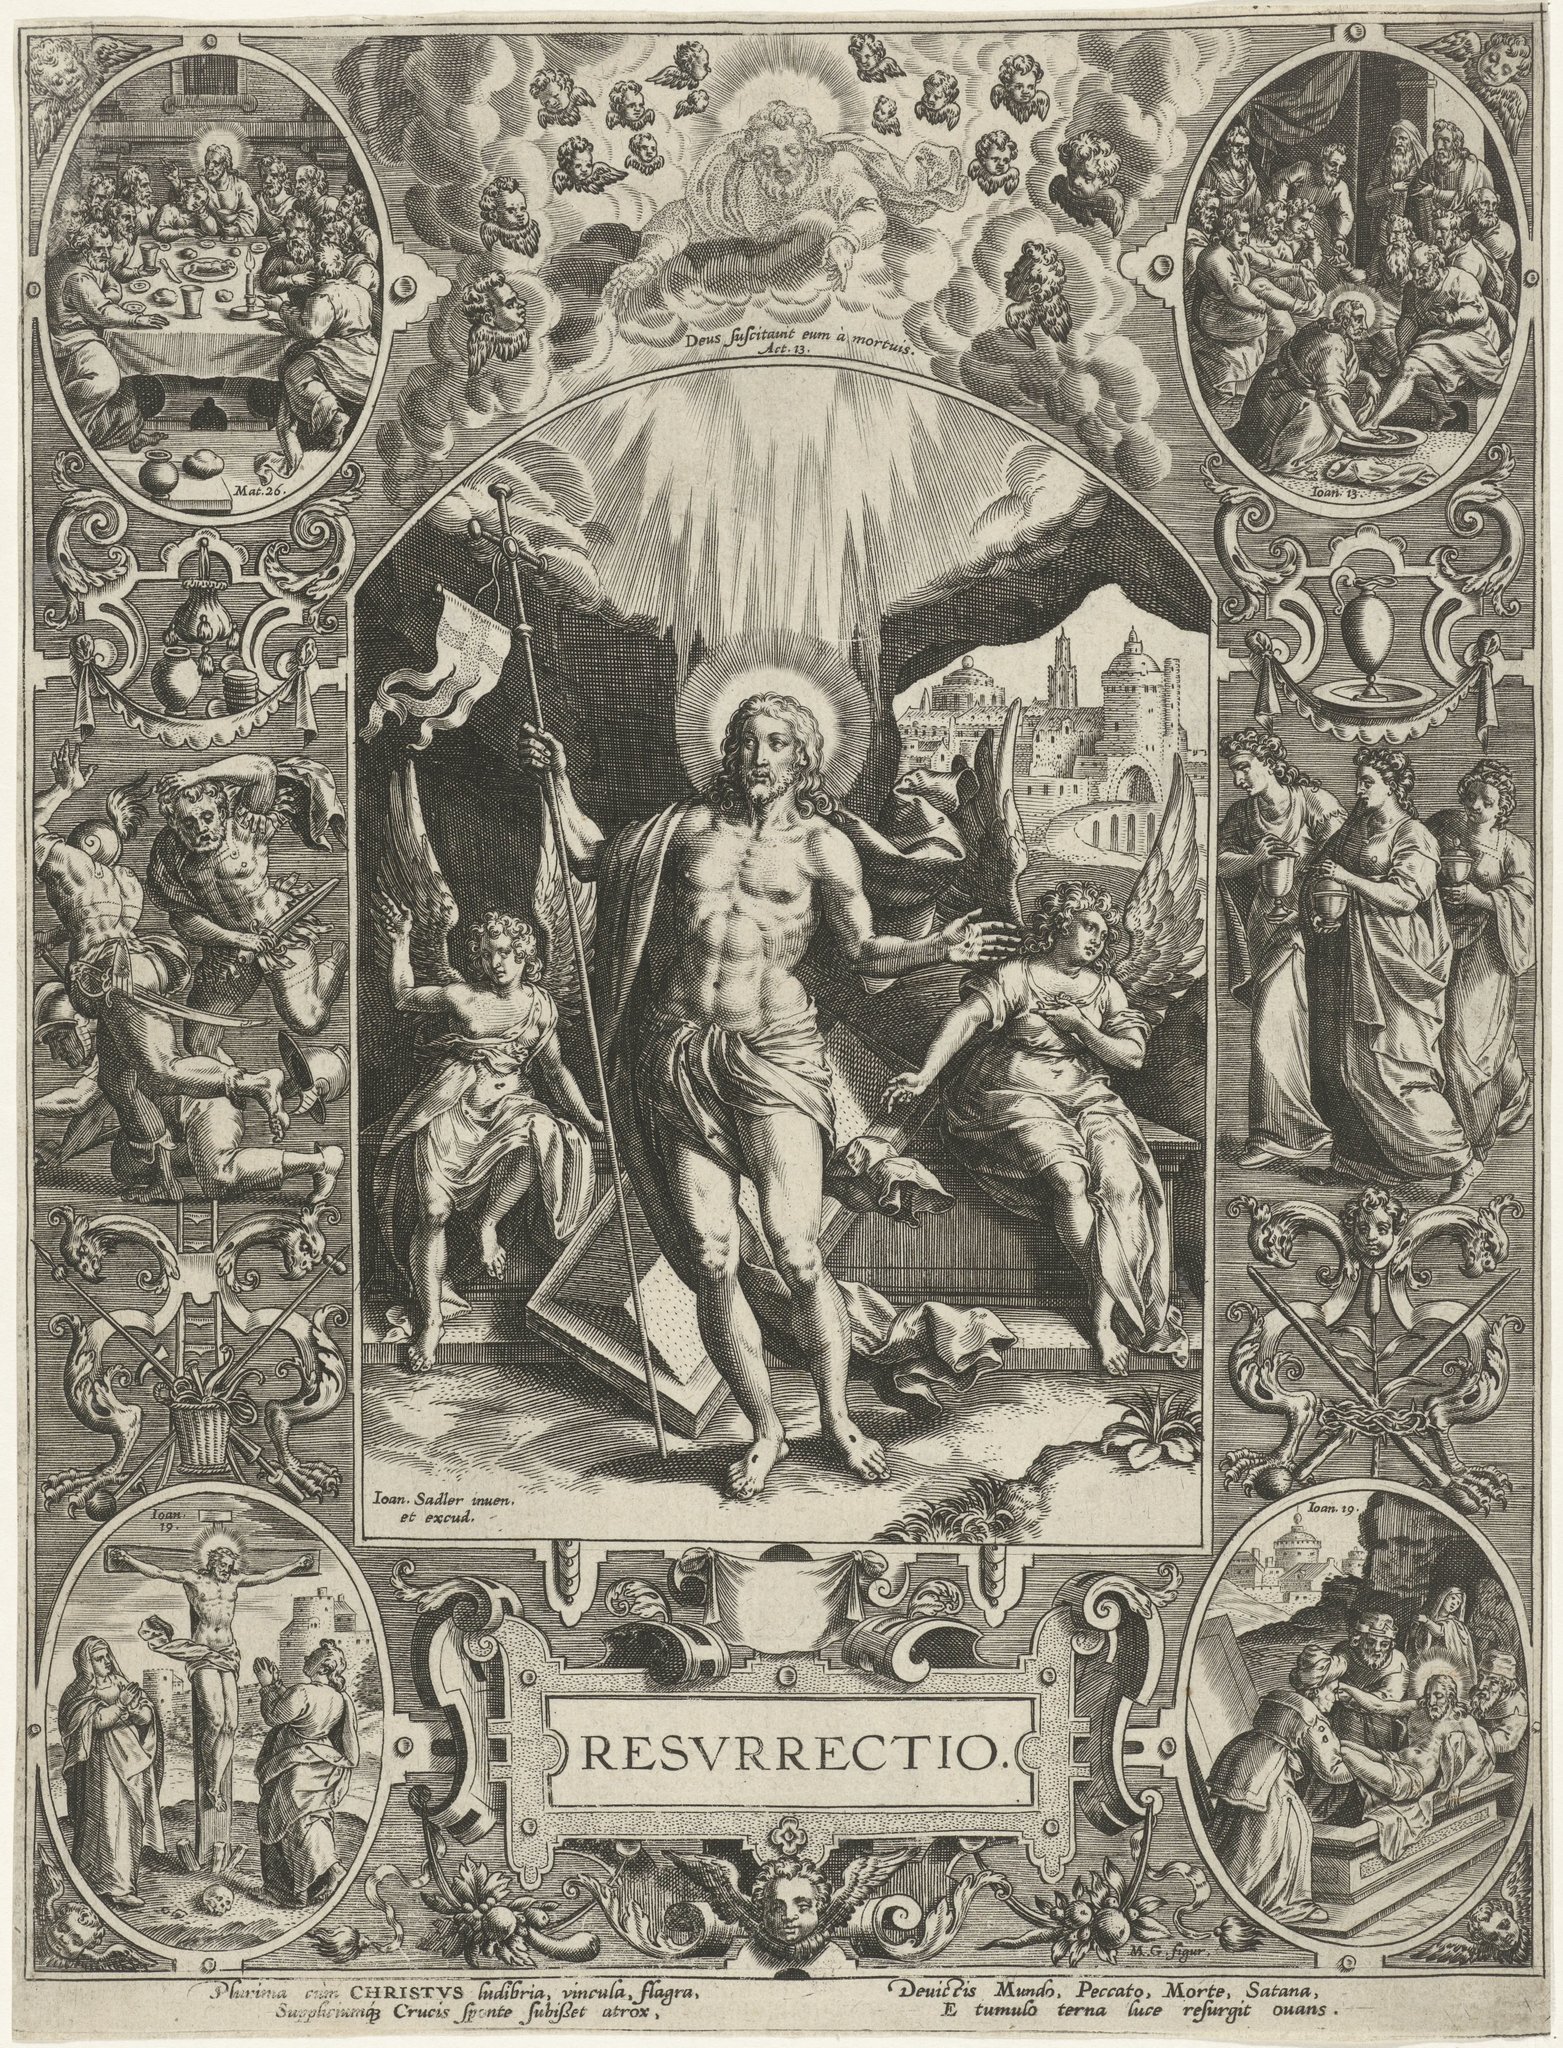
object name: print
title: Opstanding van Christus: Pasen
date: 1560-1600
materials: paper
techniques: engraving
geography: antwerp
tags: easter, christ's entombment (possibly by angels), cherubs, i.e. children's heads with wings, the episode of the last supper, christ washes peter's feet, christ, usually holding a banner, arises from the grave; often combined with sleeping and/or frightened soldiers, god the father as bearded old man, usually with crown or tiara or sceptre and/or globe, crucified christ with mary and john on either side of the cross; holy rood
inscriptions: collector's mark: Lugt 2228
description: Christus verrijst uit zijn graf. Aan weerszijden van zijn graf een engel. In ornamentlijst links vluchtende soldaten en rechts de drie vrouwen die naar het graf gaan. In de vier hoeken scènes uit de passie van Christus in ovalen. Middenboven engelenkoren met God de Vader.